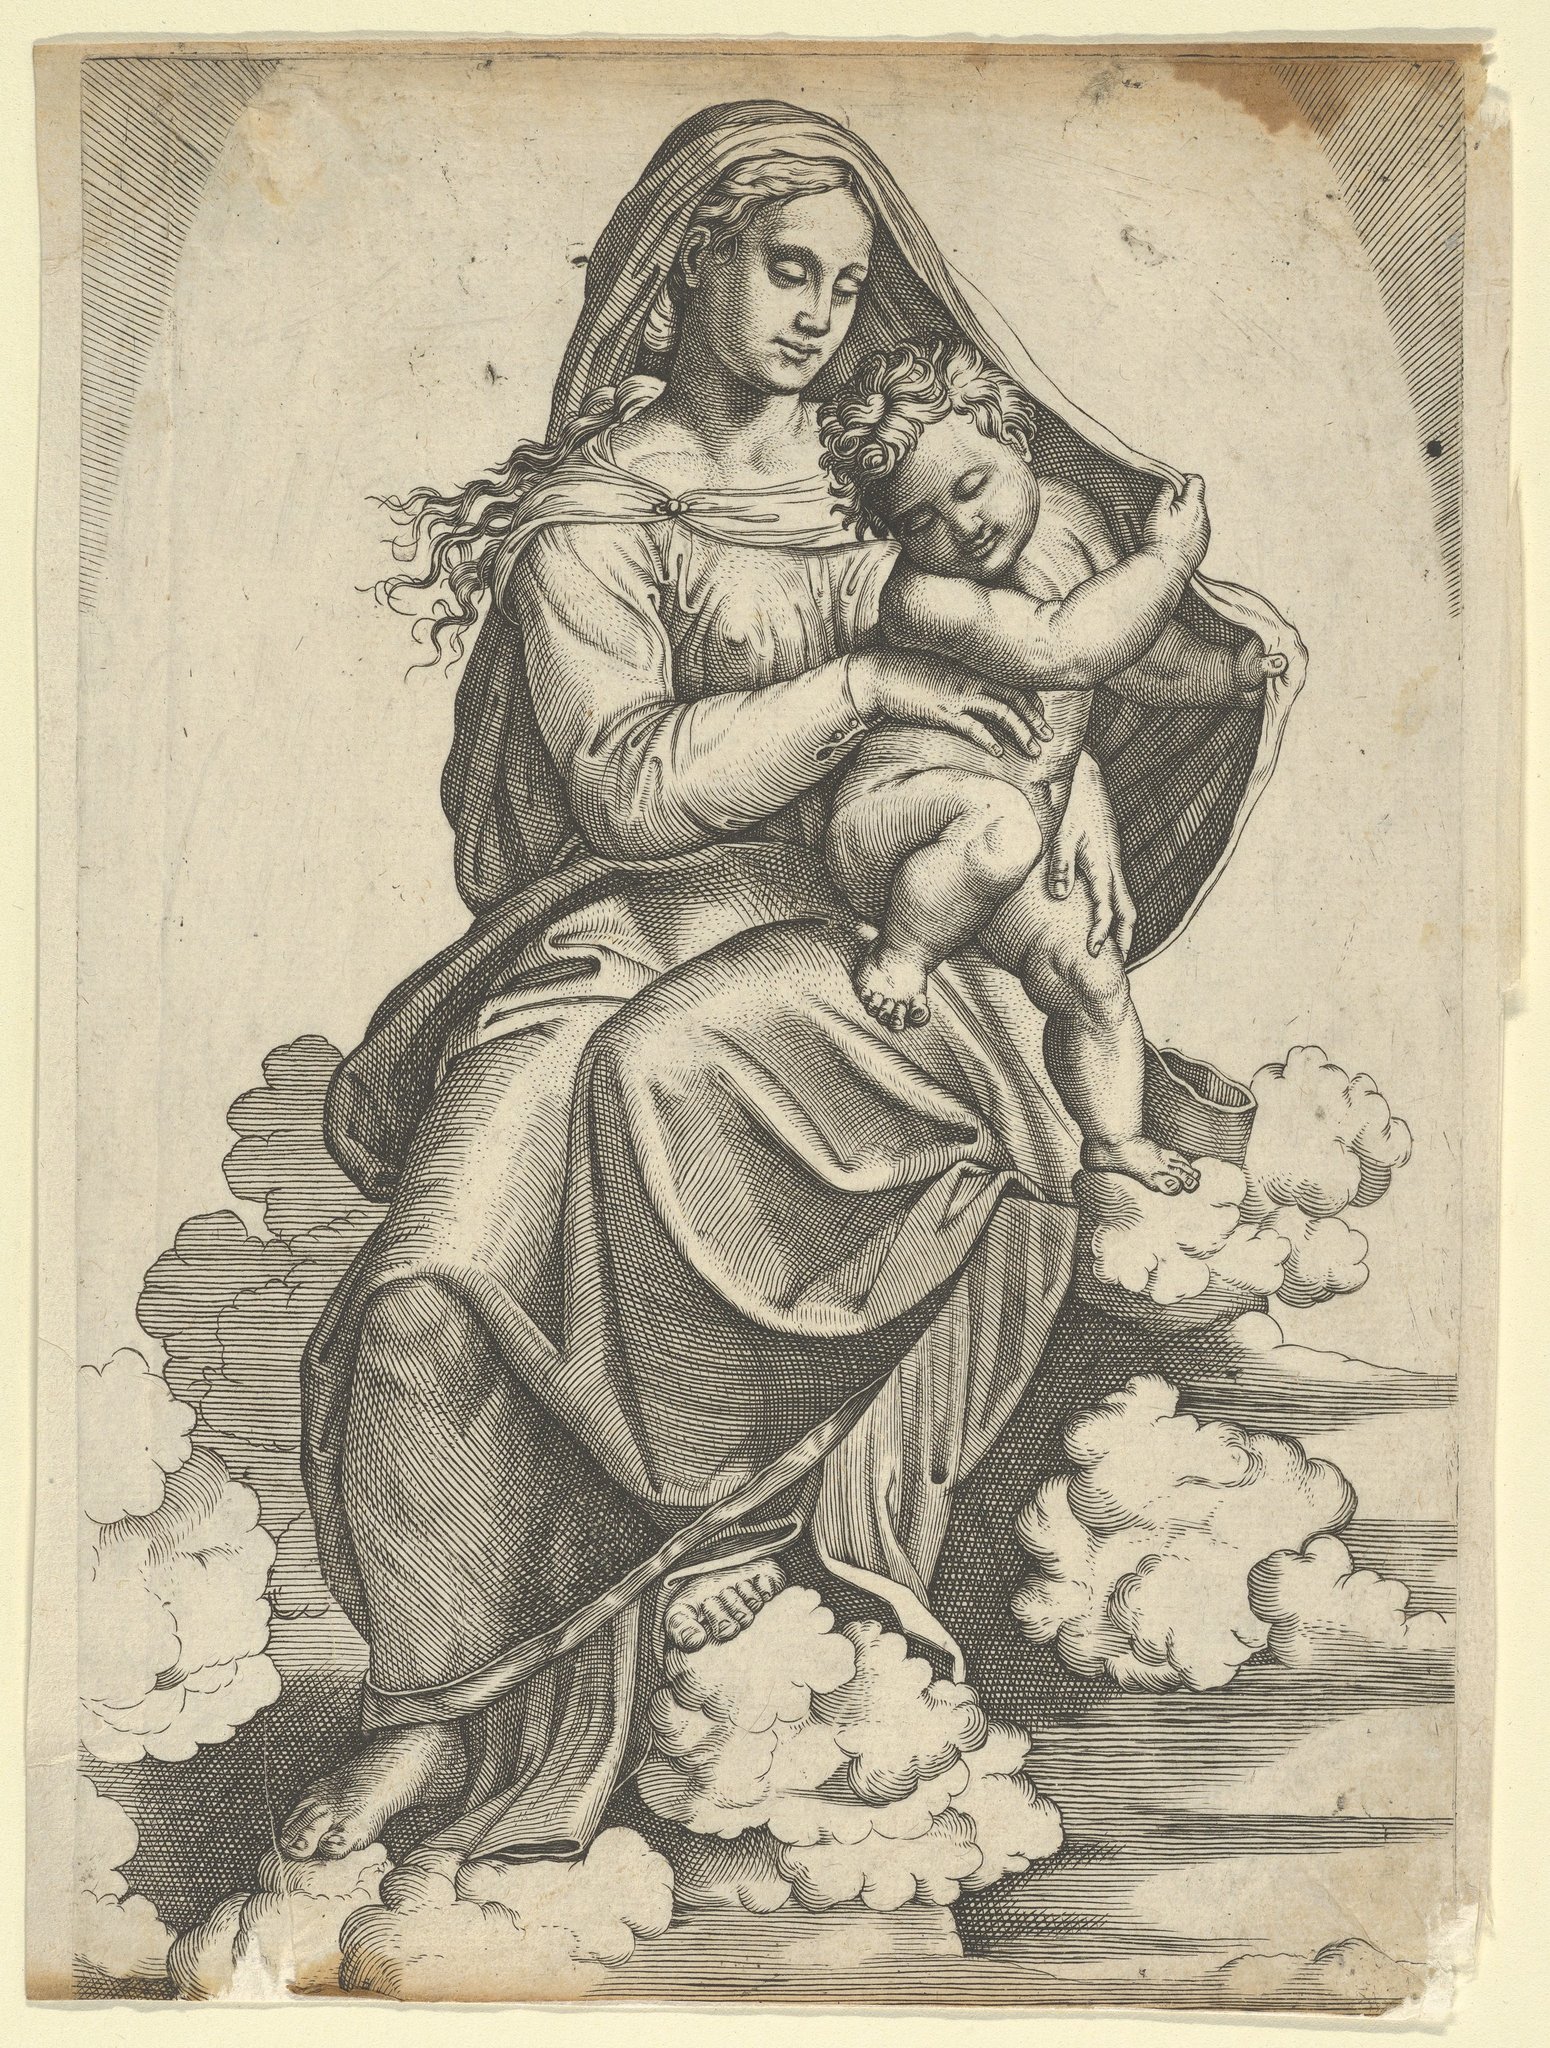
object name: print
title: Madonna and Child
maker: Anonymous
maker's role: artist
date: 1512-1520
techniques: engraving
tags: madonna and child